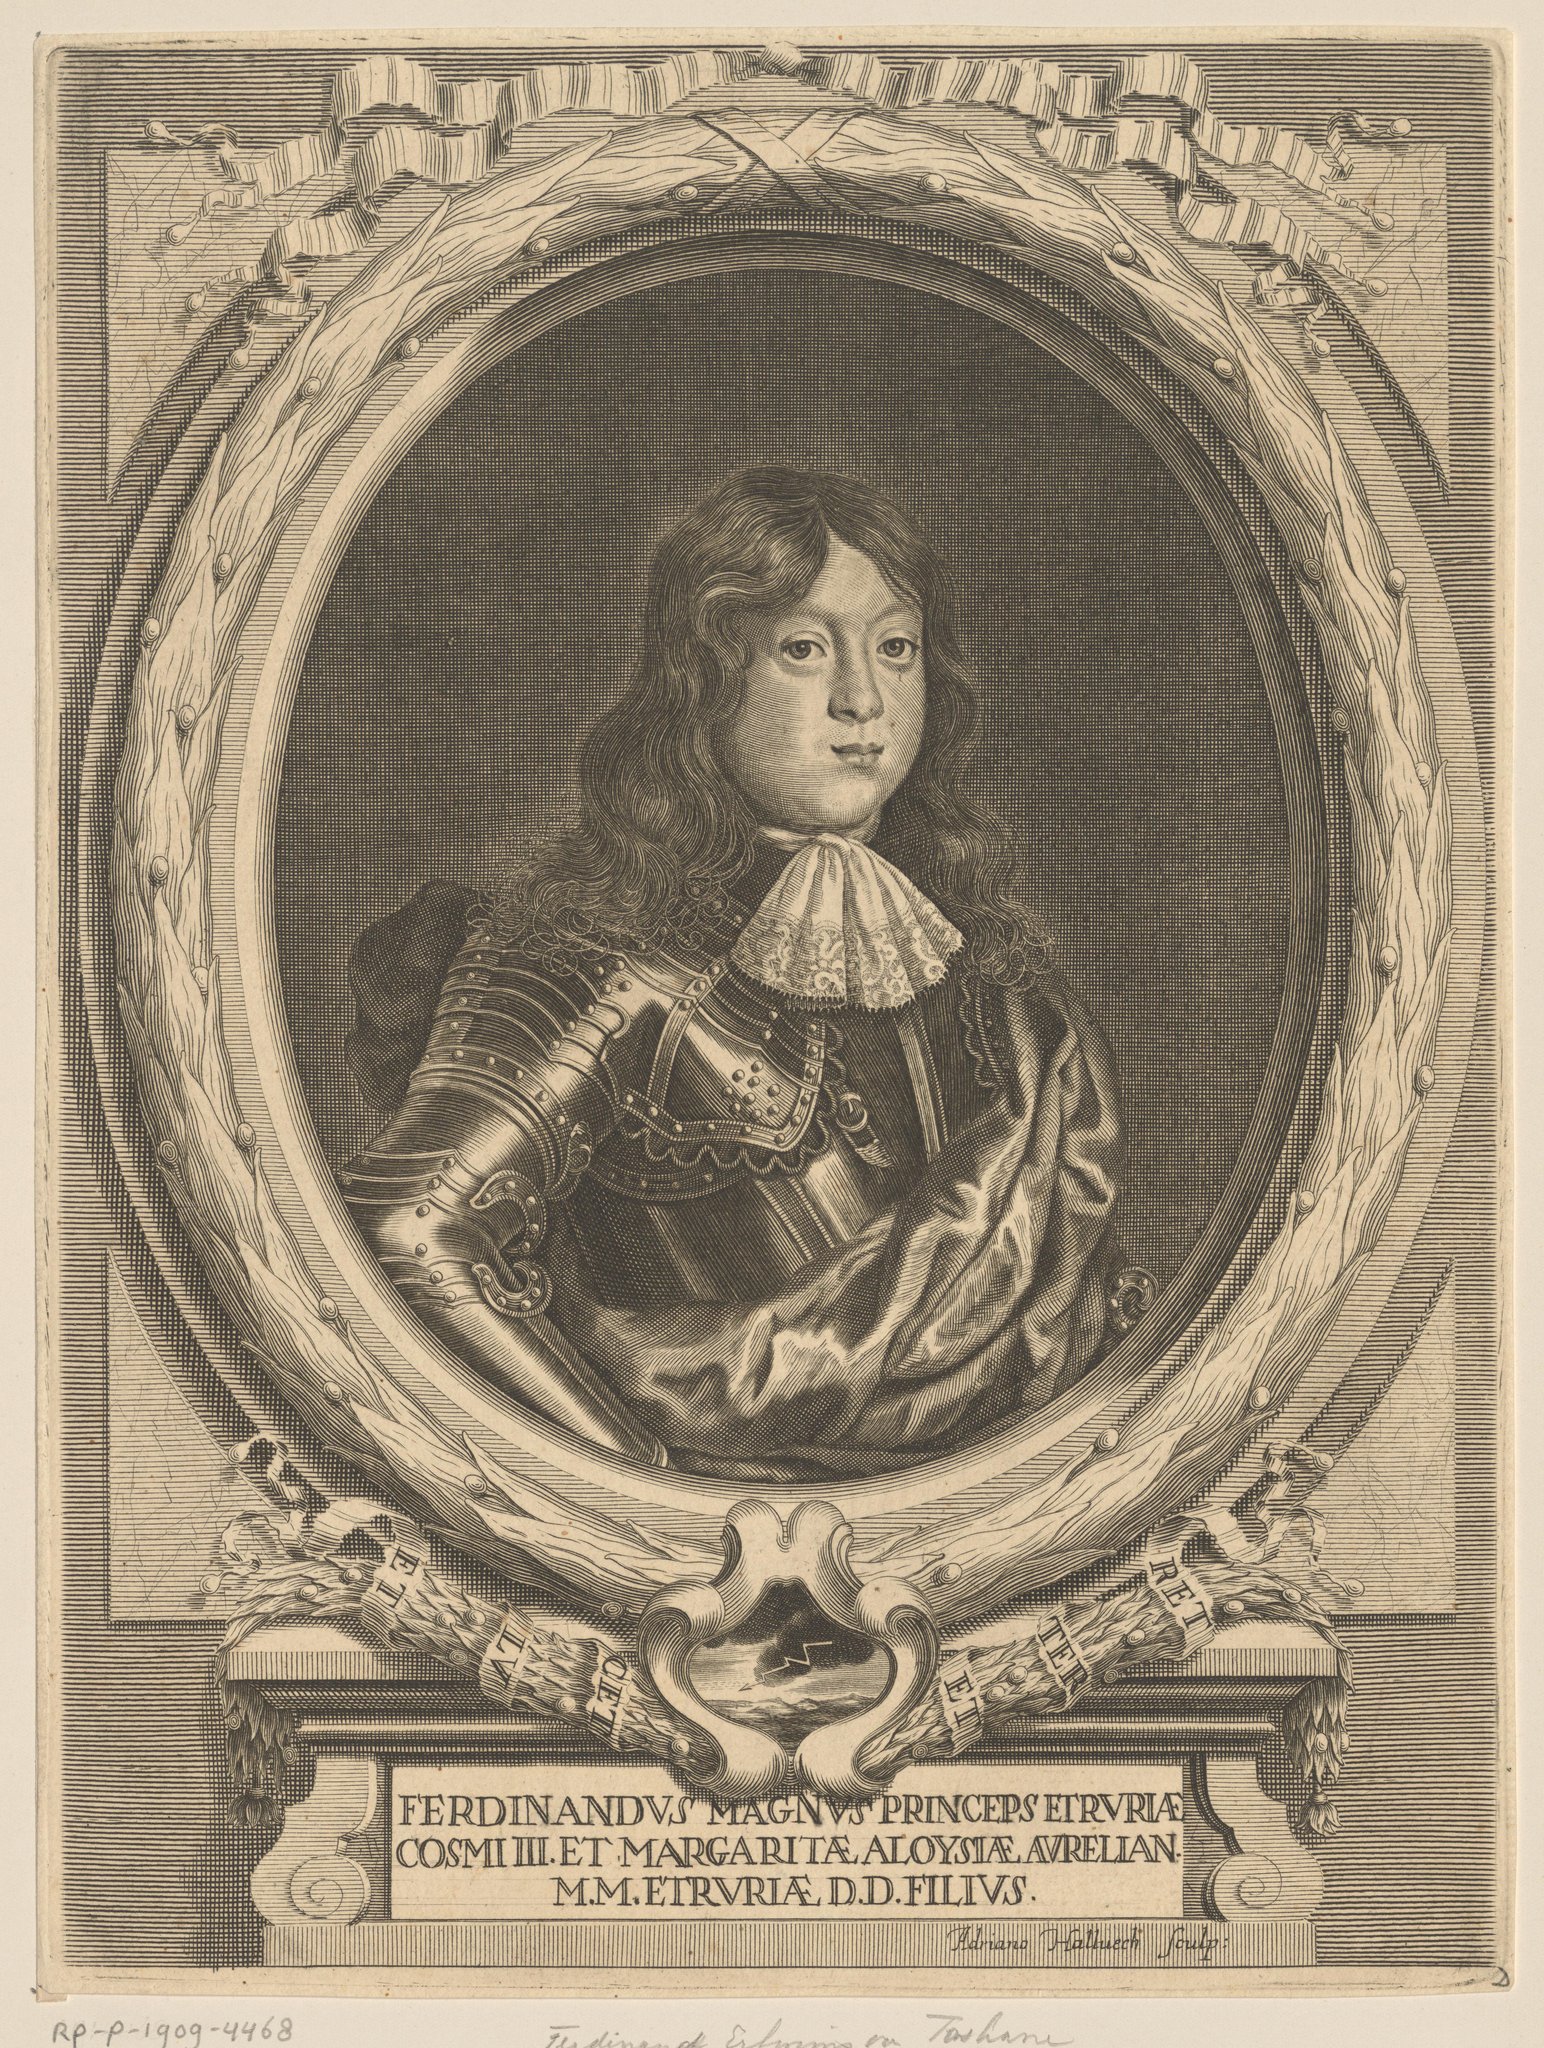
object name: print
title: Portretten van de familie De' Medici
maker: adriaen haelwegh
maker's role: print maker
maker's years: 1637-1702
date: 1673-1680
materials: paper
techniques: engraving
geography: northern netherlands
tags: armour, historical persons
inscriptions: collector's mark: Lugt 2228